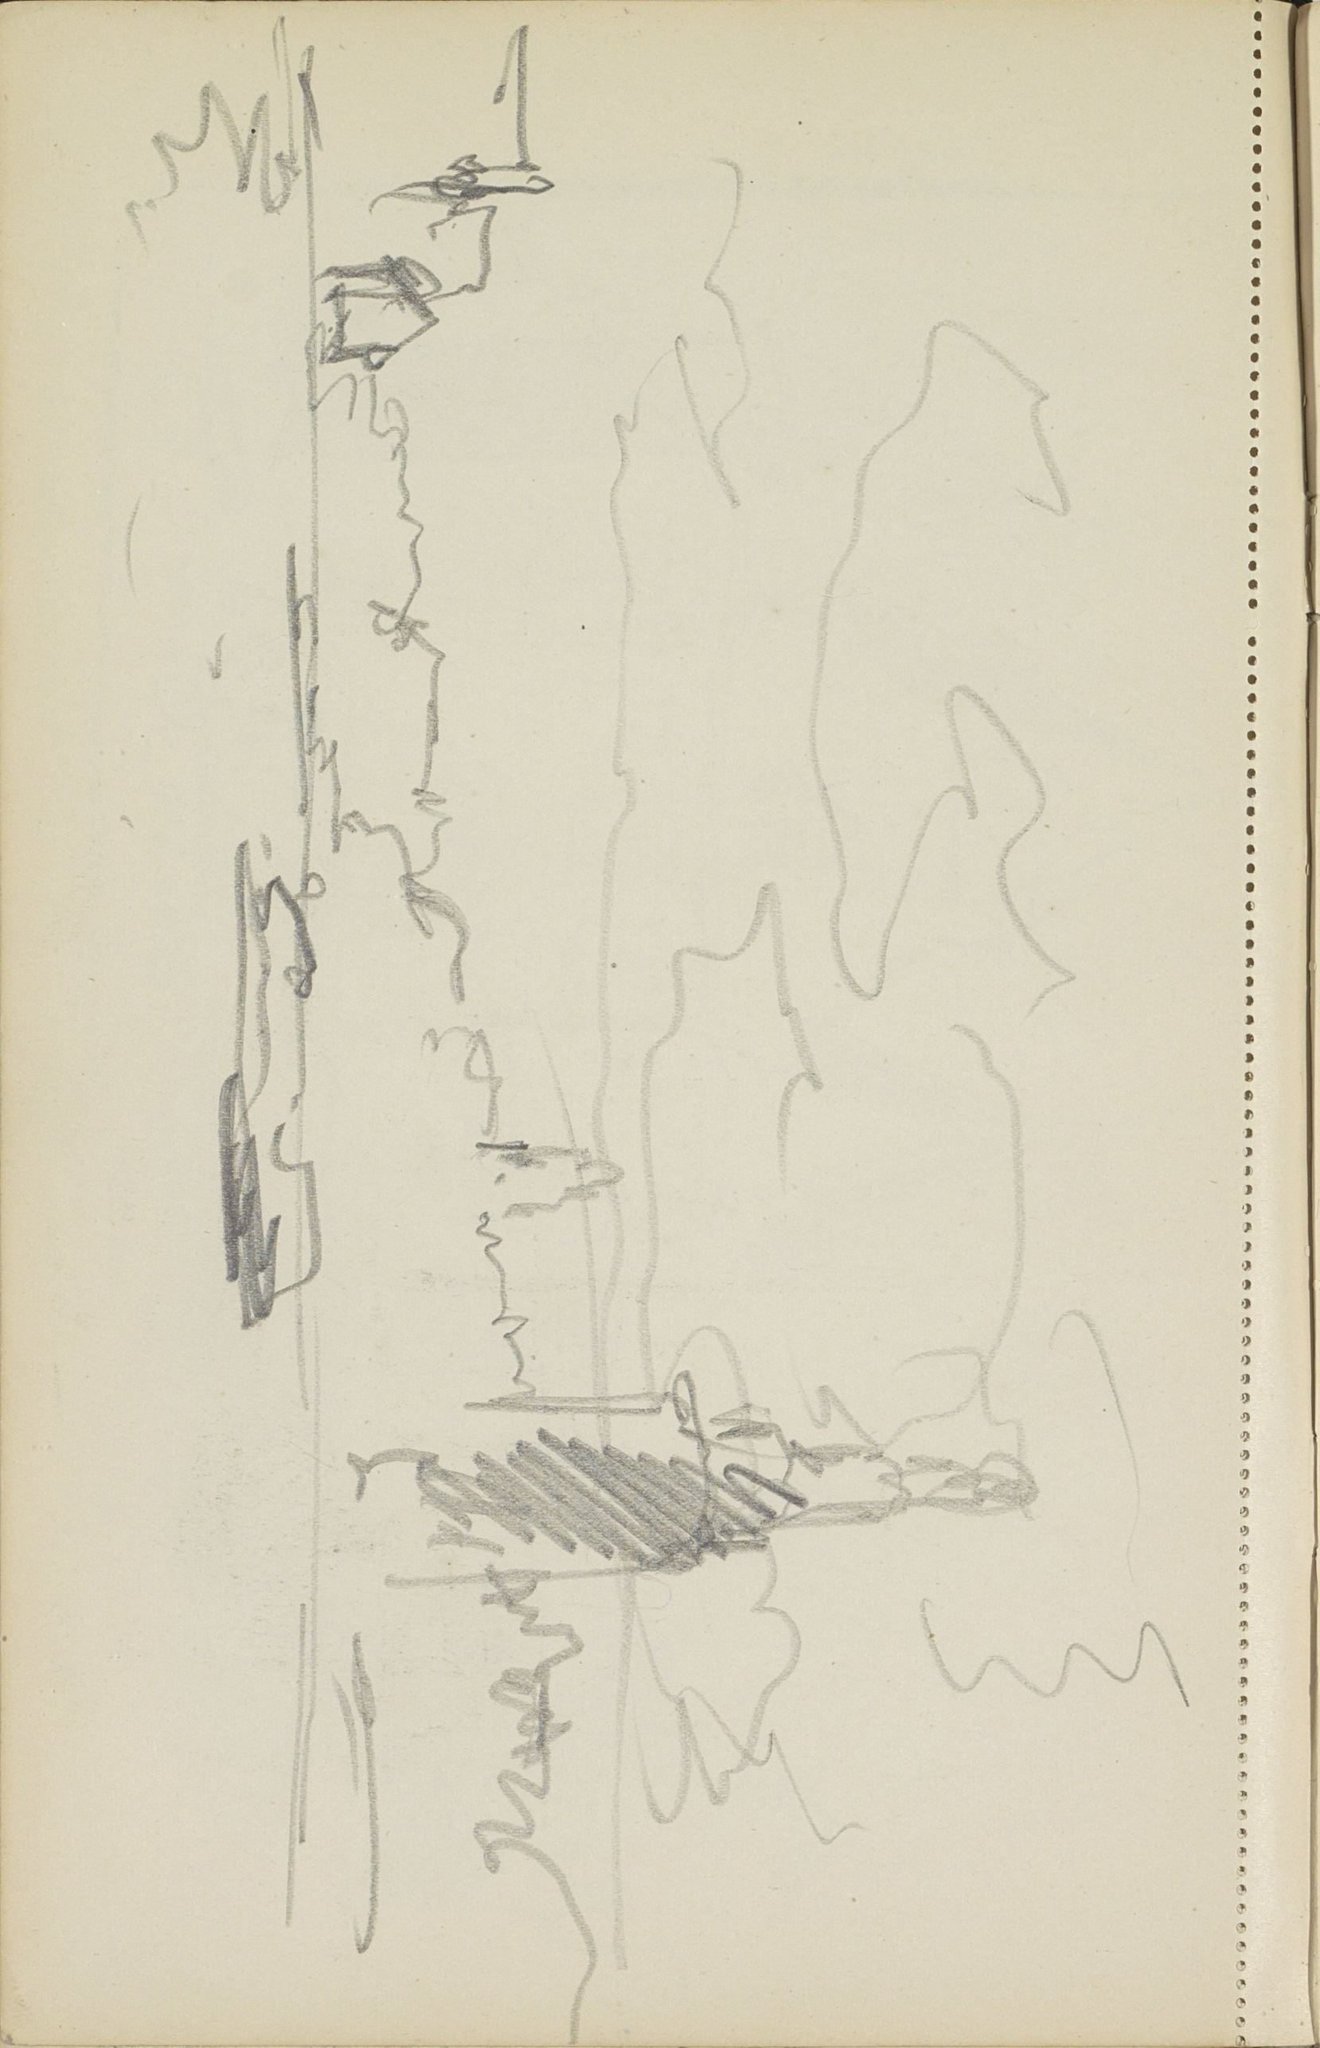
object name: sketchbook leaf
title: Montelbaanstoren aan de Oudeschans te Amsterdam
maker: cornelis vreedenburgh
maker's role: draughtsman, print maker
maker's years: 1880-1946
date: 1890-1946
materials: paper, pencil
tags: city-view, and landscape with man-made constructions, tower (of house or building)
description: Blad 33 verso uit een schetsboek met 56 bladen.